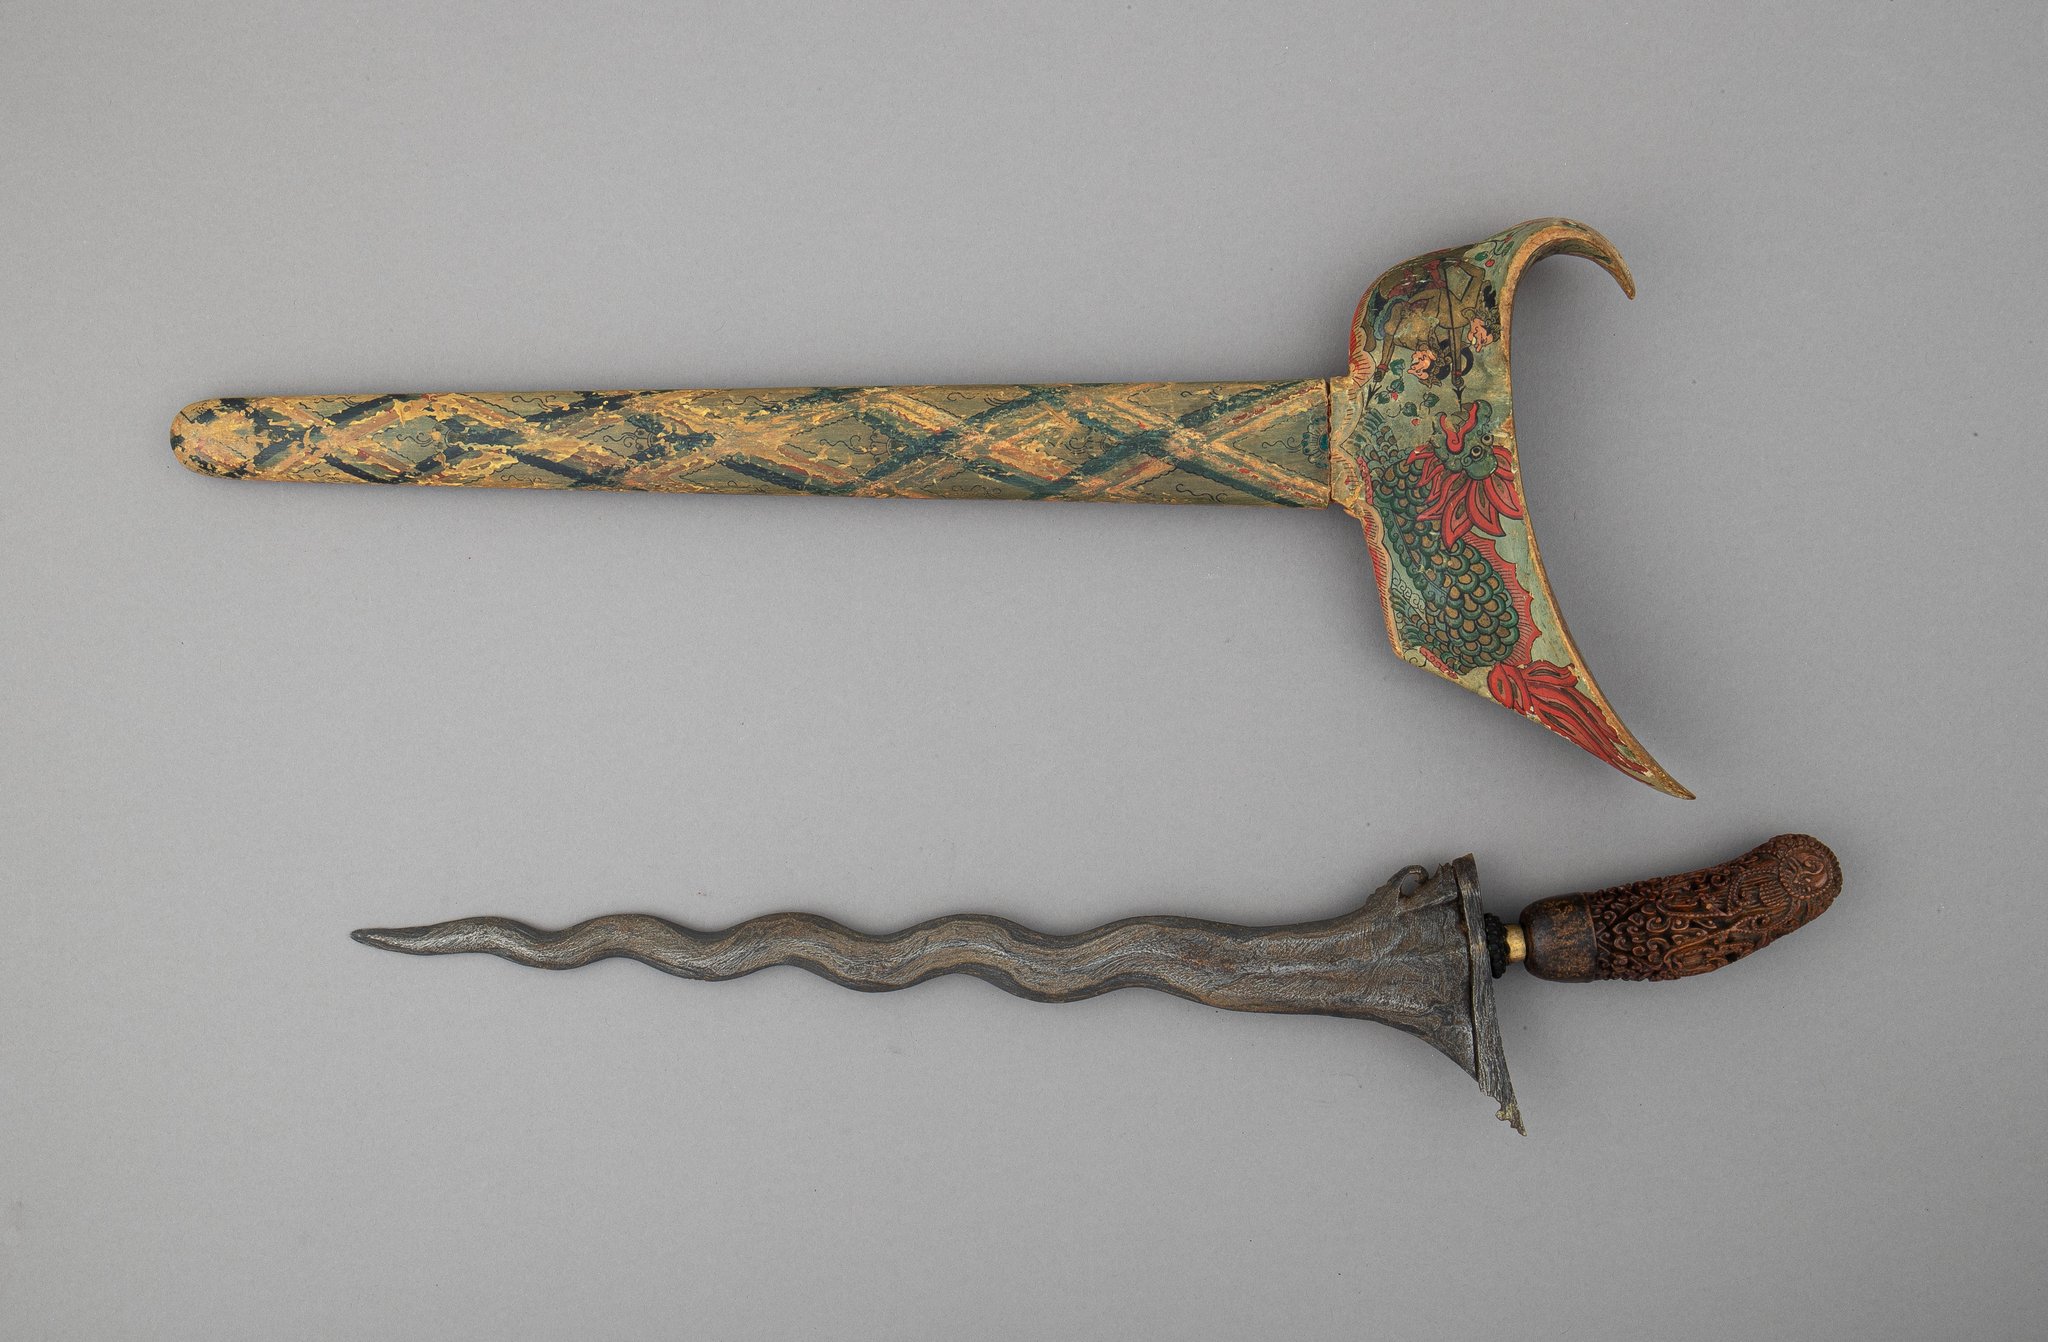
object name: kris with sheath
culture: madurese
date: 1501-1900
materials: copper alloy, steel, wood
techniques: polychromy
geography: indonesia